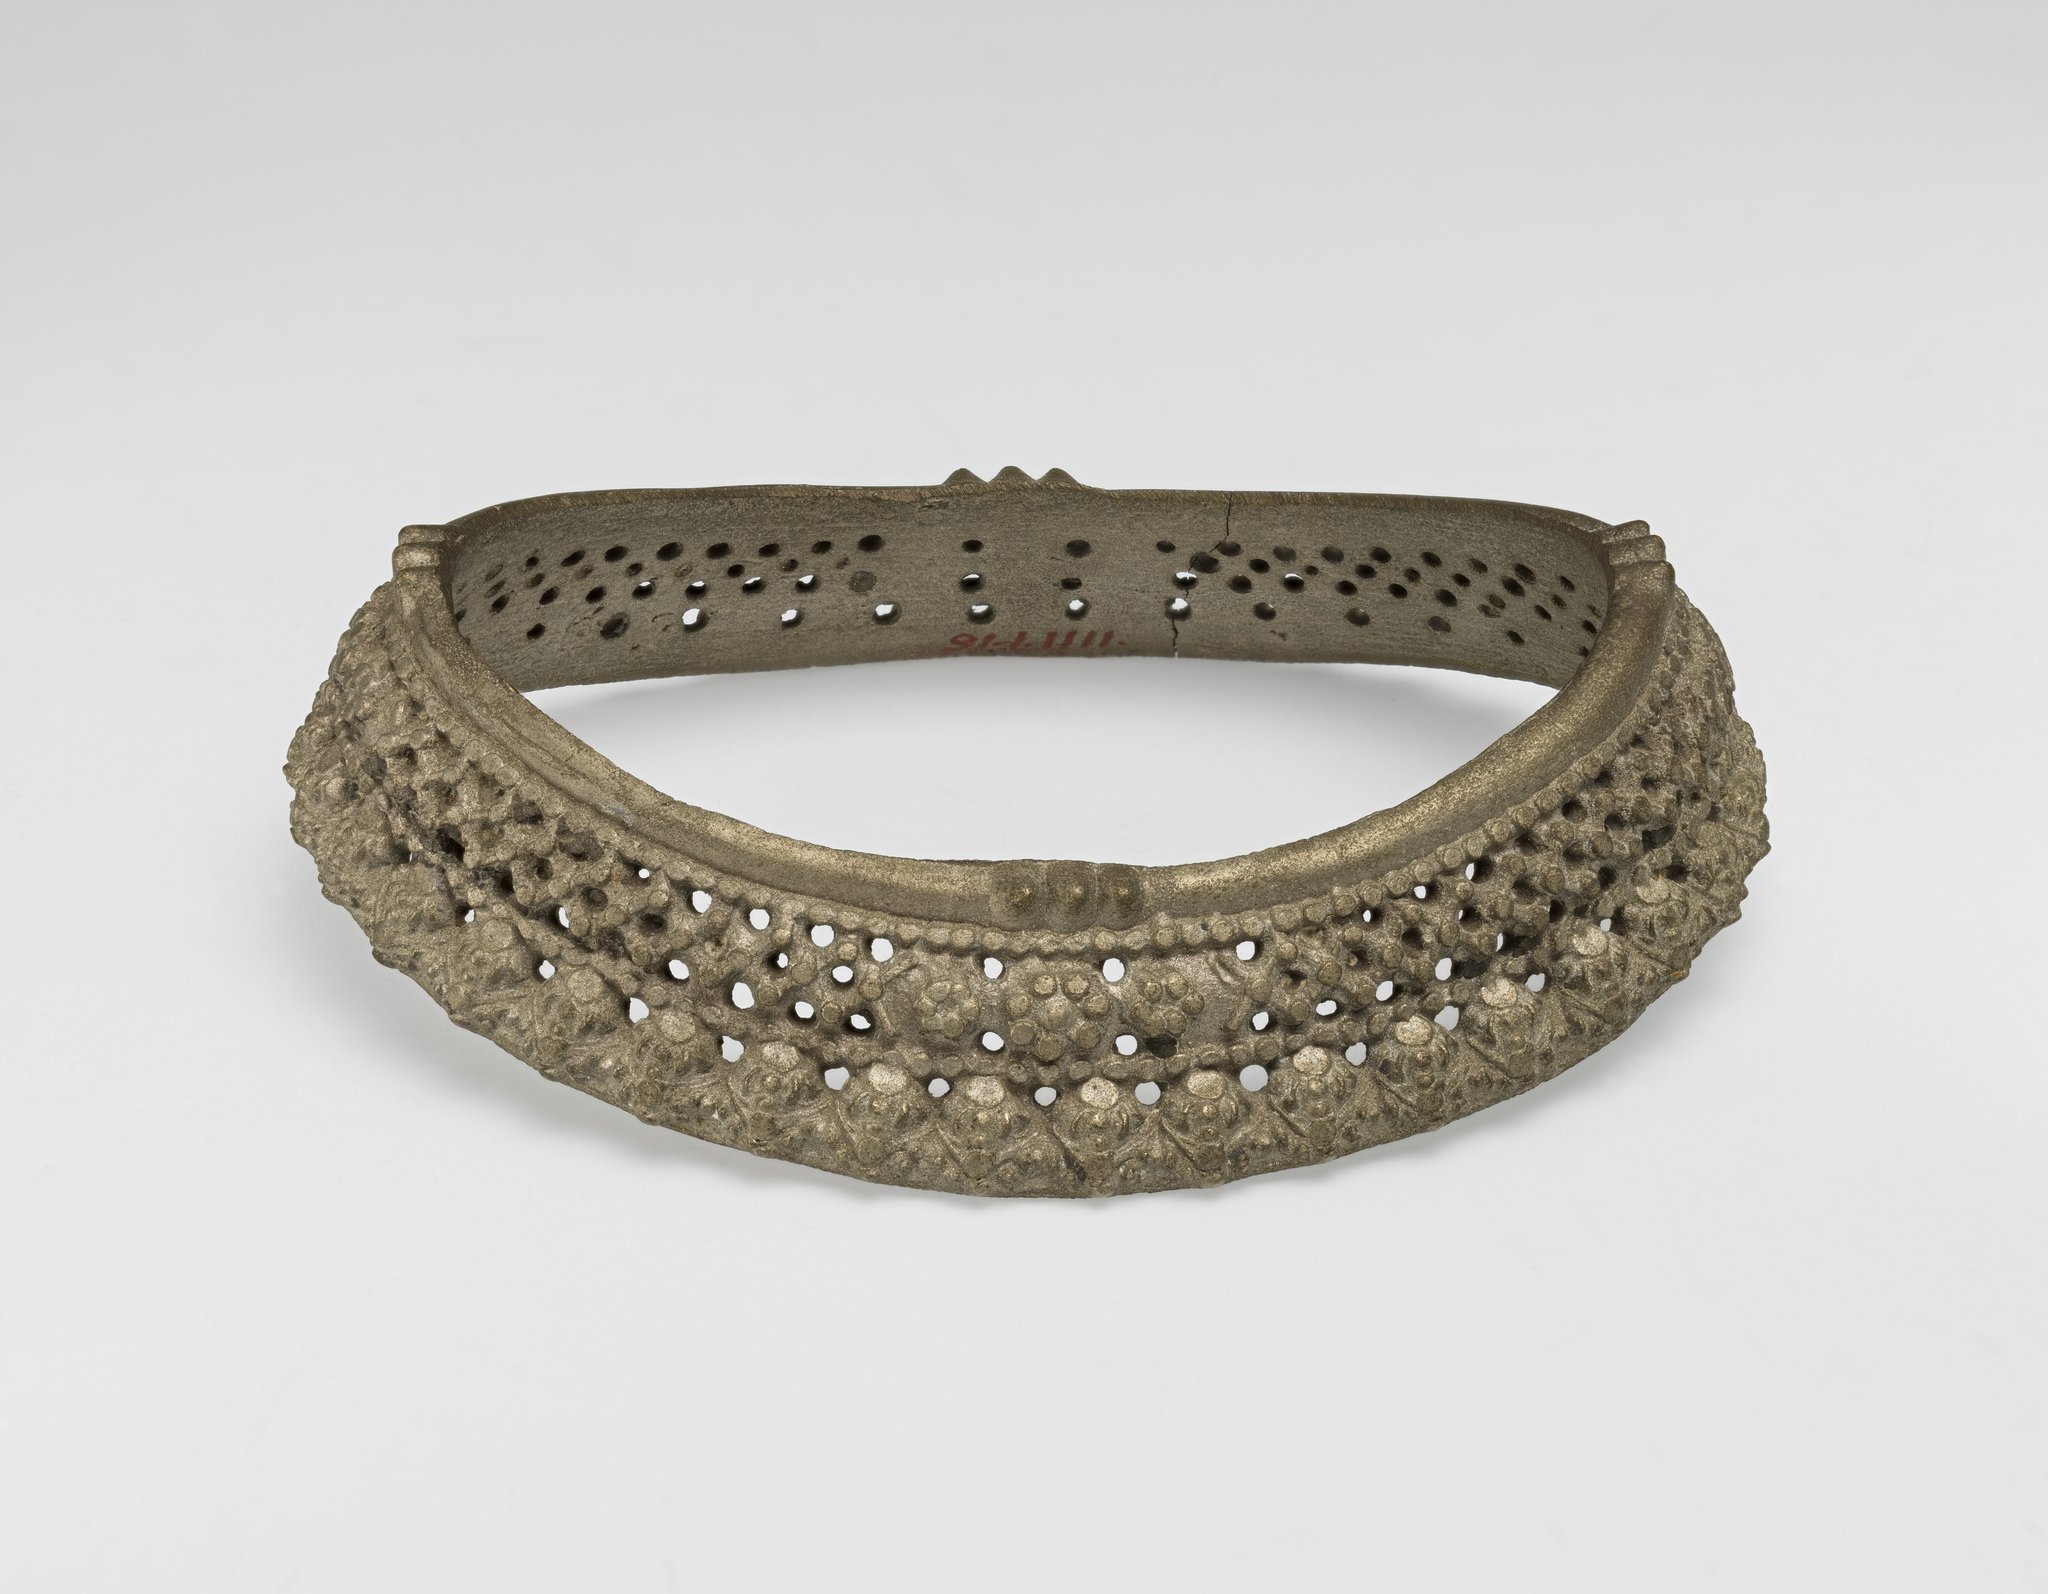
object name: anklet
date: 1801-1900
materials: iron, silver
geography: india